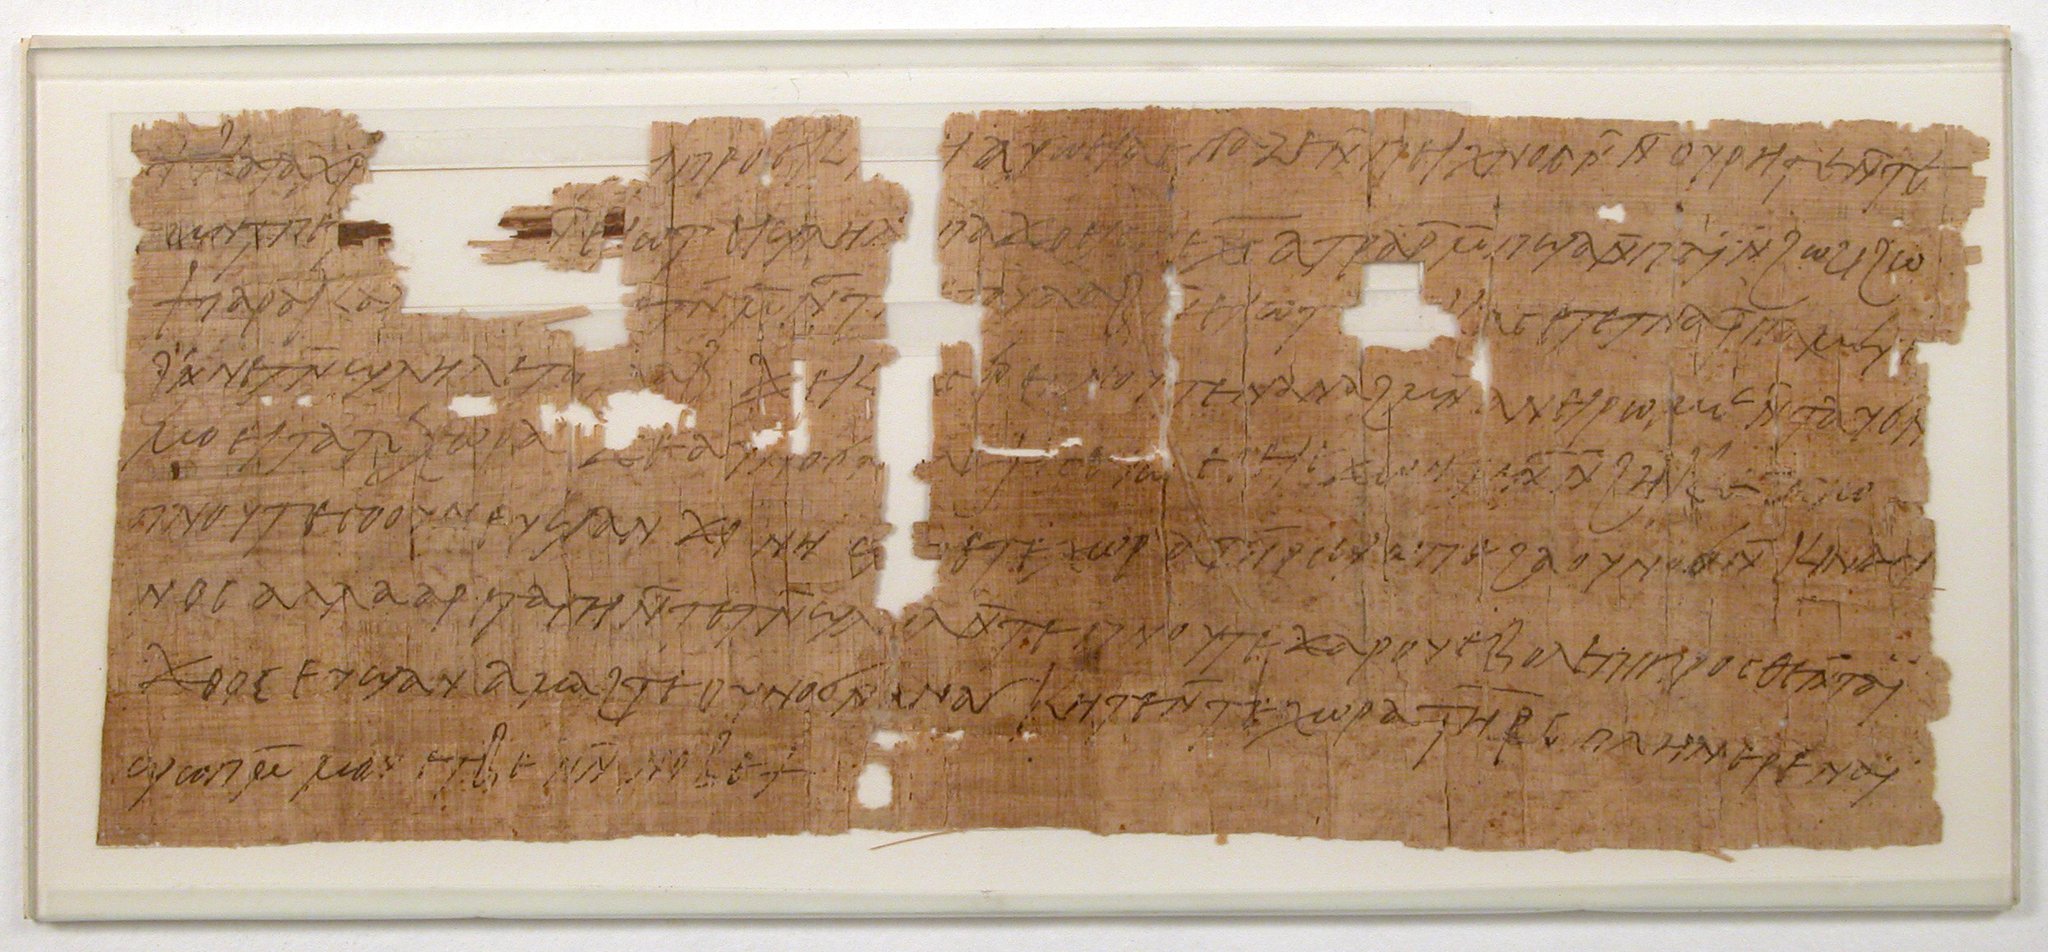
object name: papyrus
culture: coptic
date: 601-700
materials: ink, papyrus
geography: egypt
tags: documents